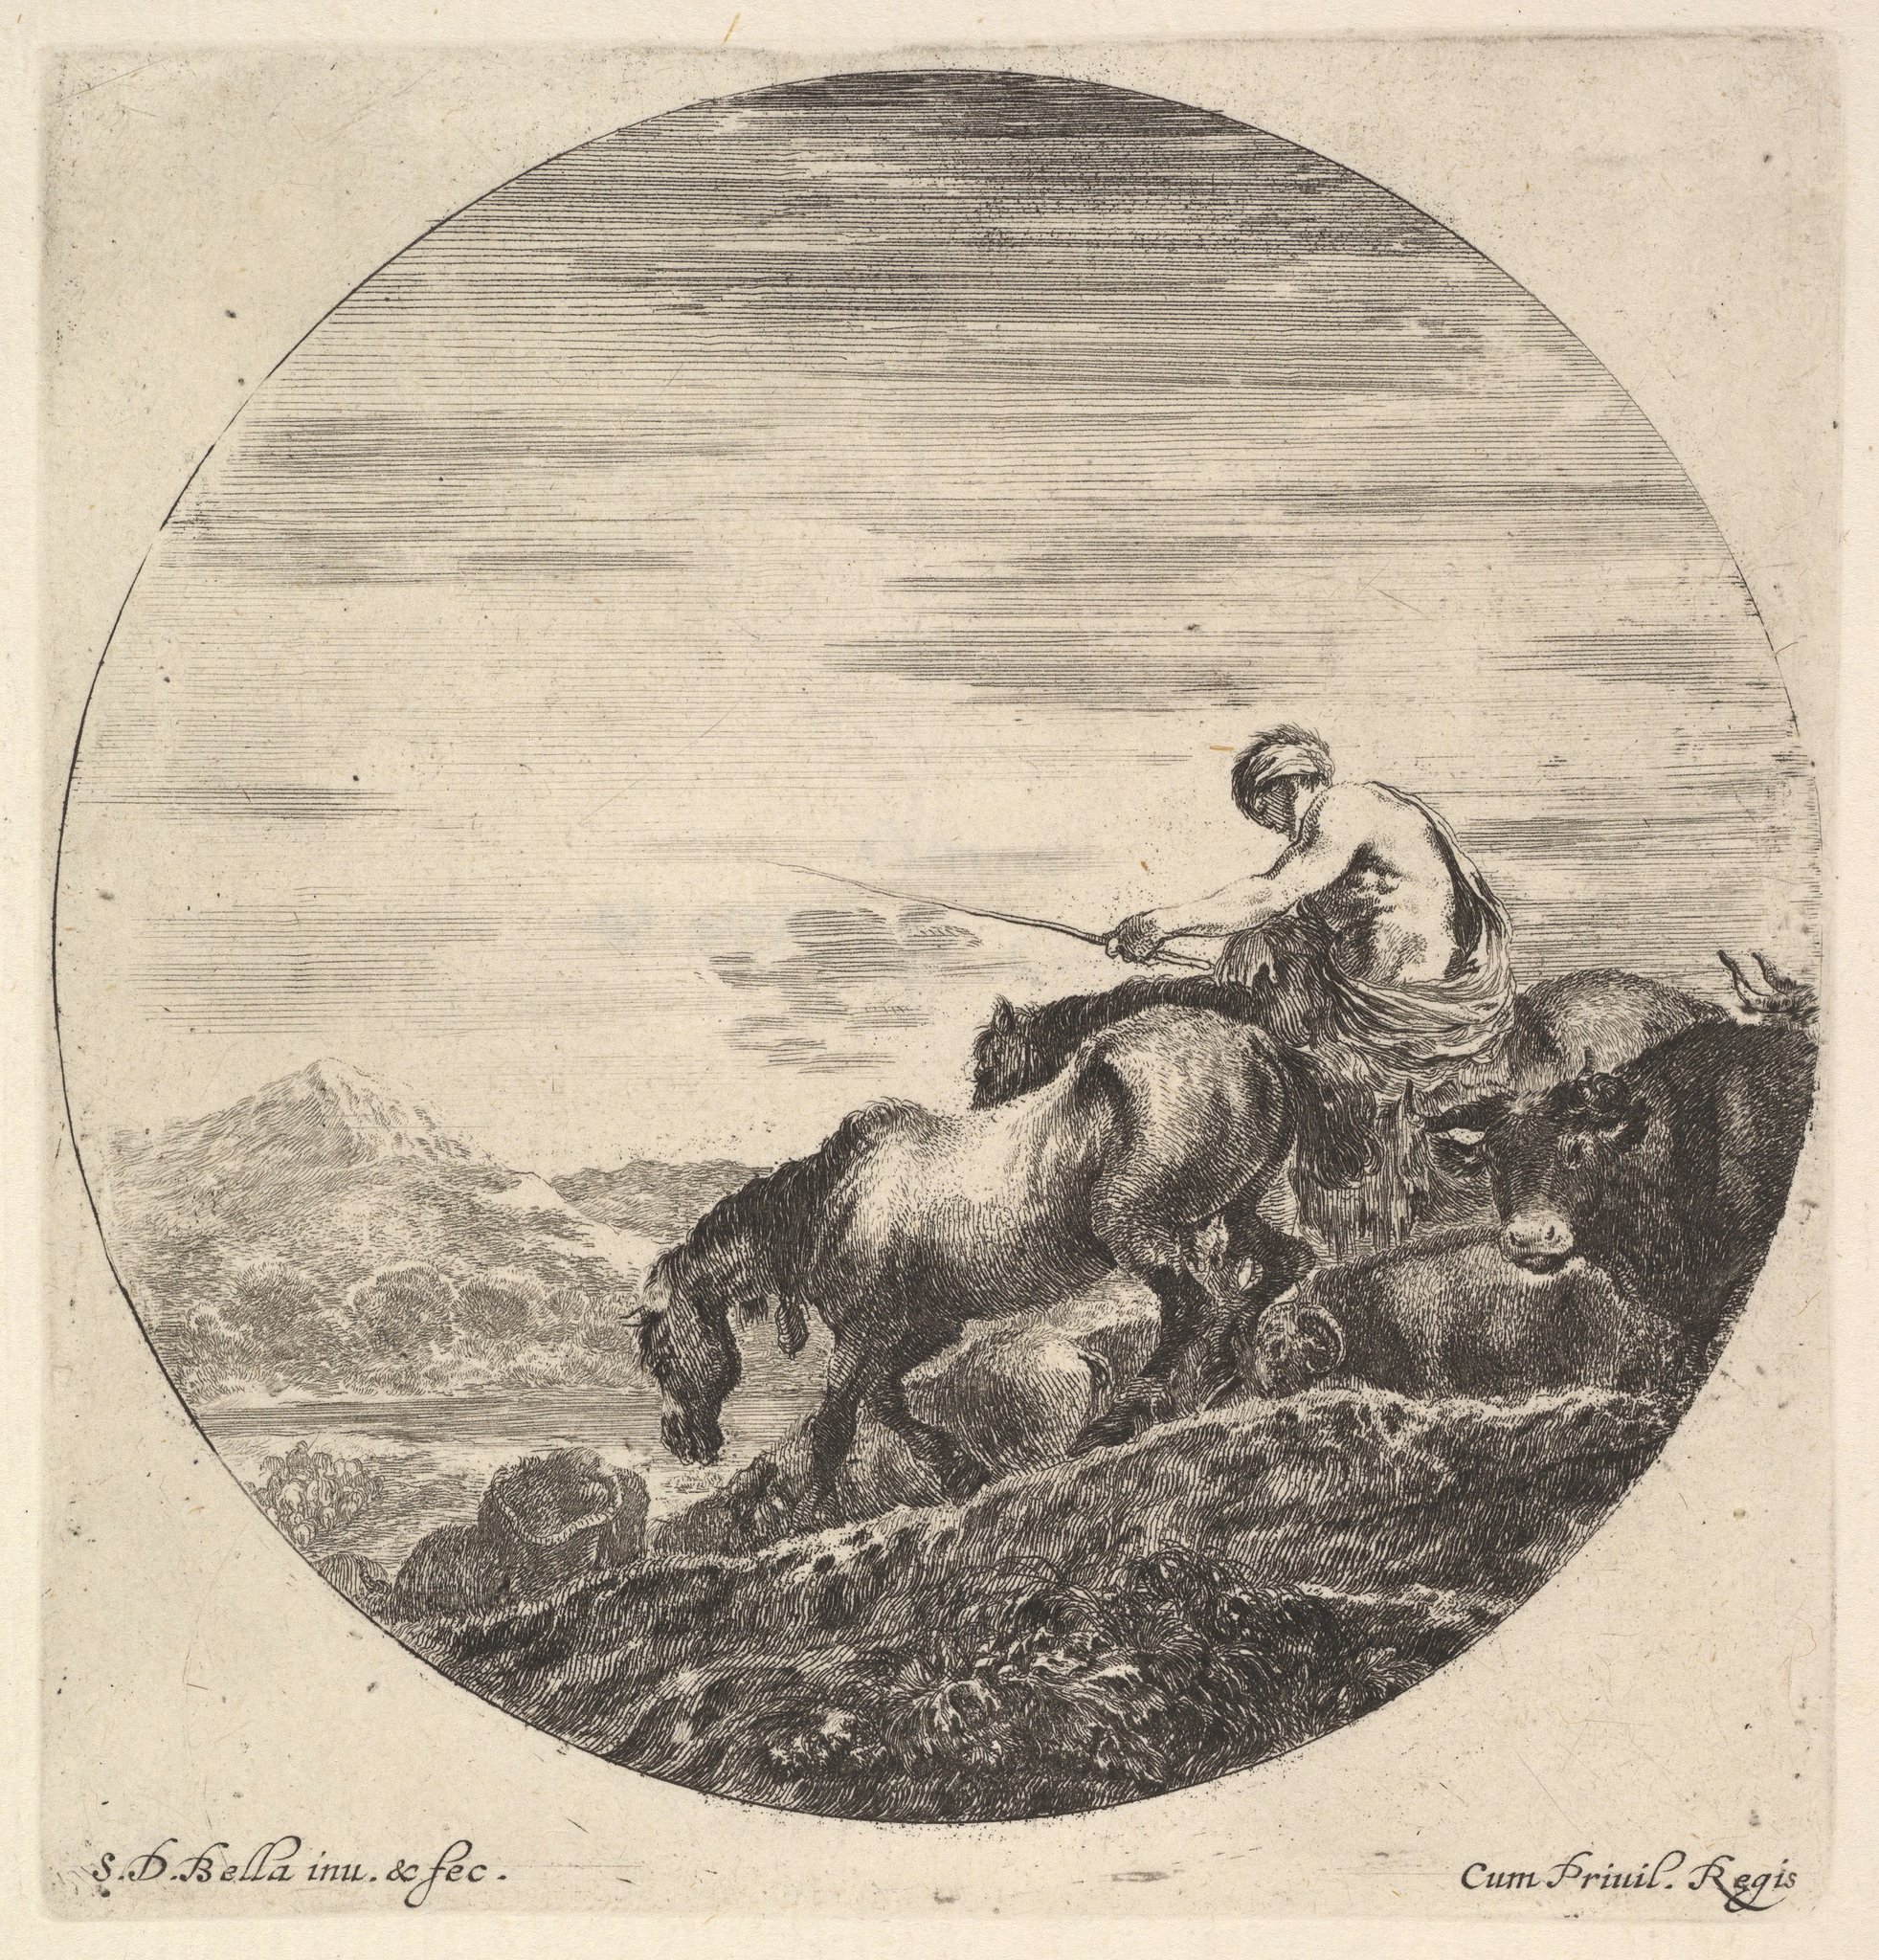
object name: print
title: A shepherd at right, facing left, driving a group of animals downhill, from "Six Animal Subjects" (Six Sujets d'Animaux)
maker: stefano della bella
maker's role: artist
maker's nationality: italian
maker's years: 1610-1664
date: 1643-1648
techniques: etching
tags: animals,men,shepherds